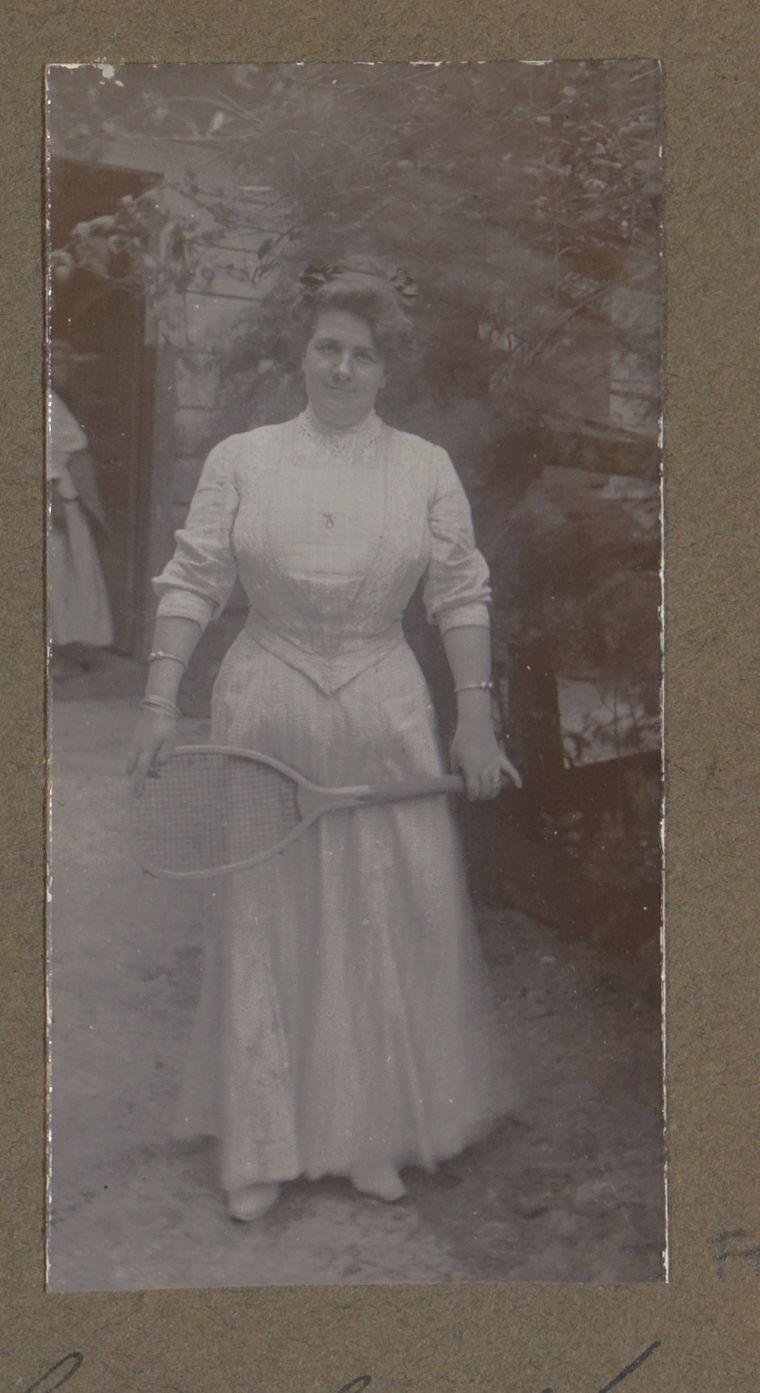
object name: photograph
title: Leve de sport!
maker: Anonymous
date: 1920-1930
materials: photographic support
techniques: gelatin silver print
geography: suriname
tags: adult woman, tennis, lawn-tennis (+ sportsman, player, etc.), suriname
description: Onderdeel van fotoalbum van een onbekende Nederlandse familie met opnames van Suriname, Europa en Nederlands-Indië.